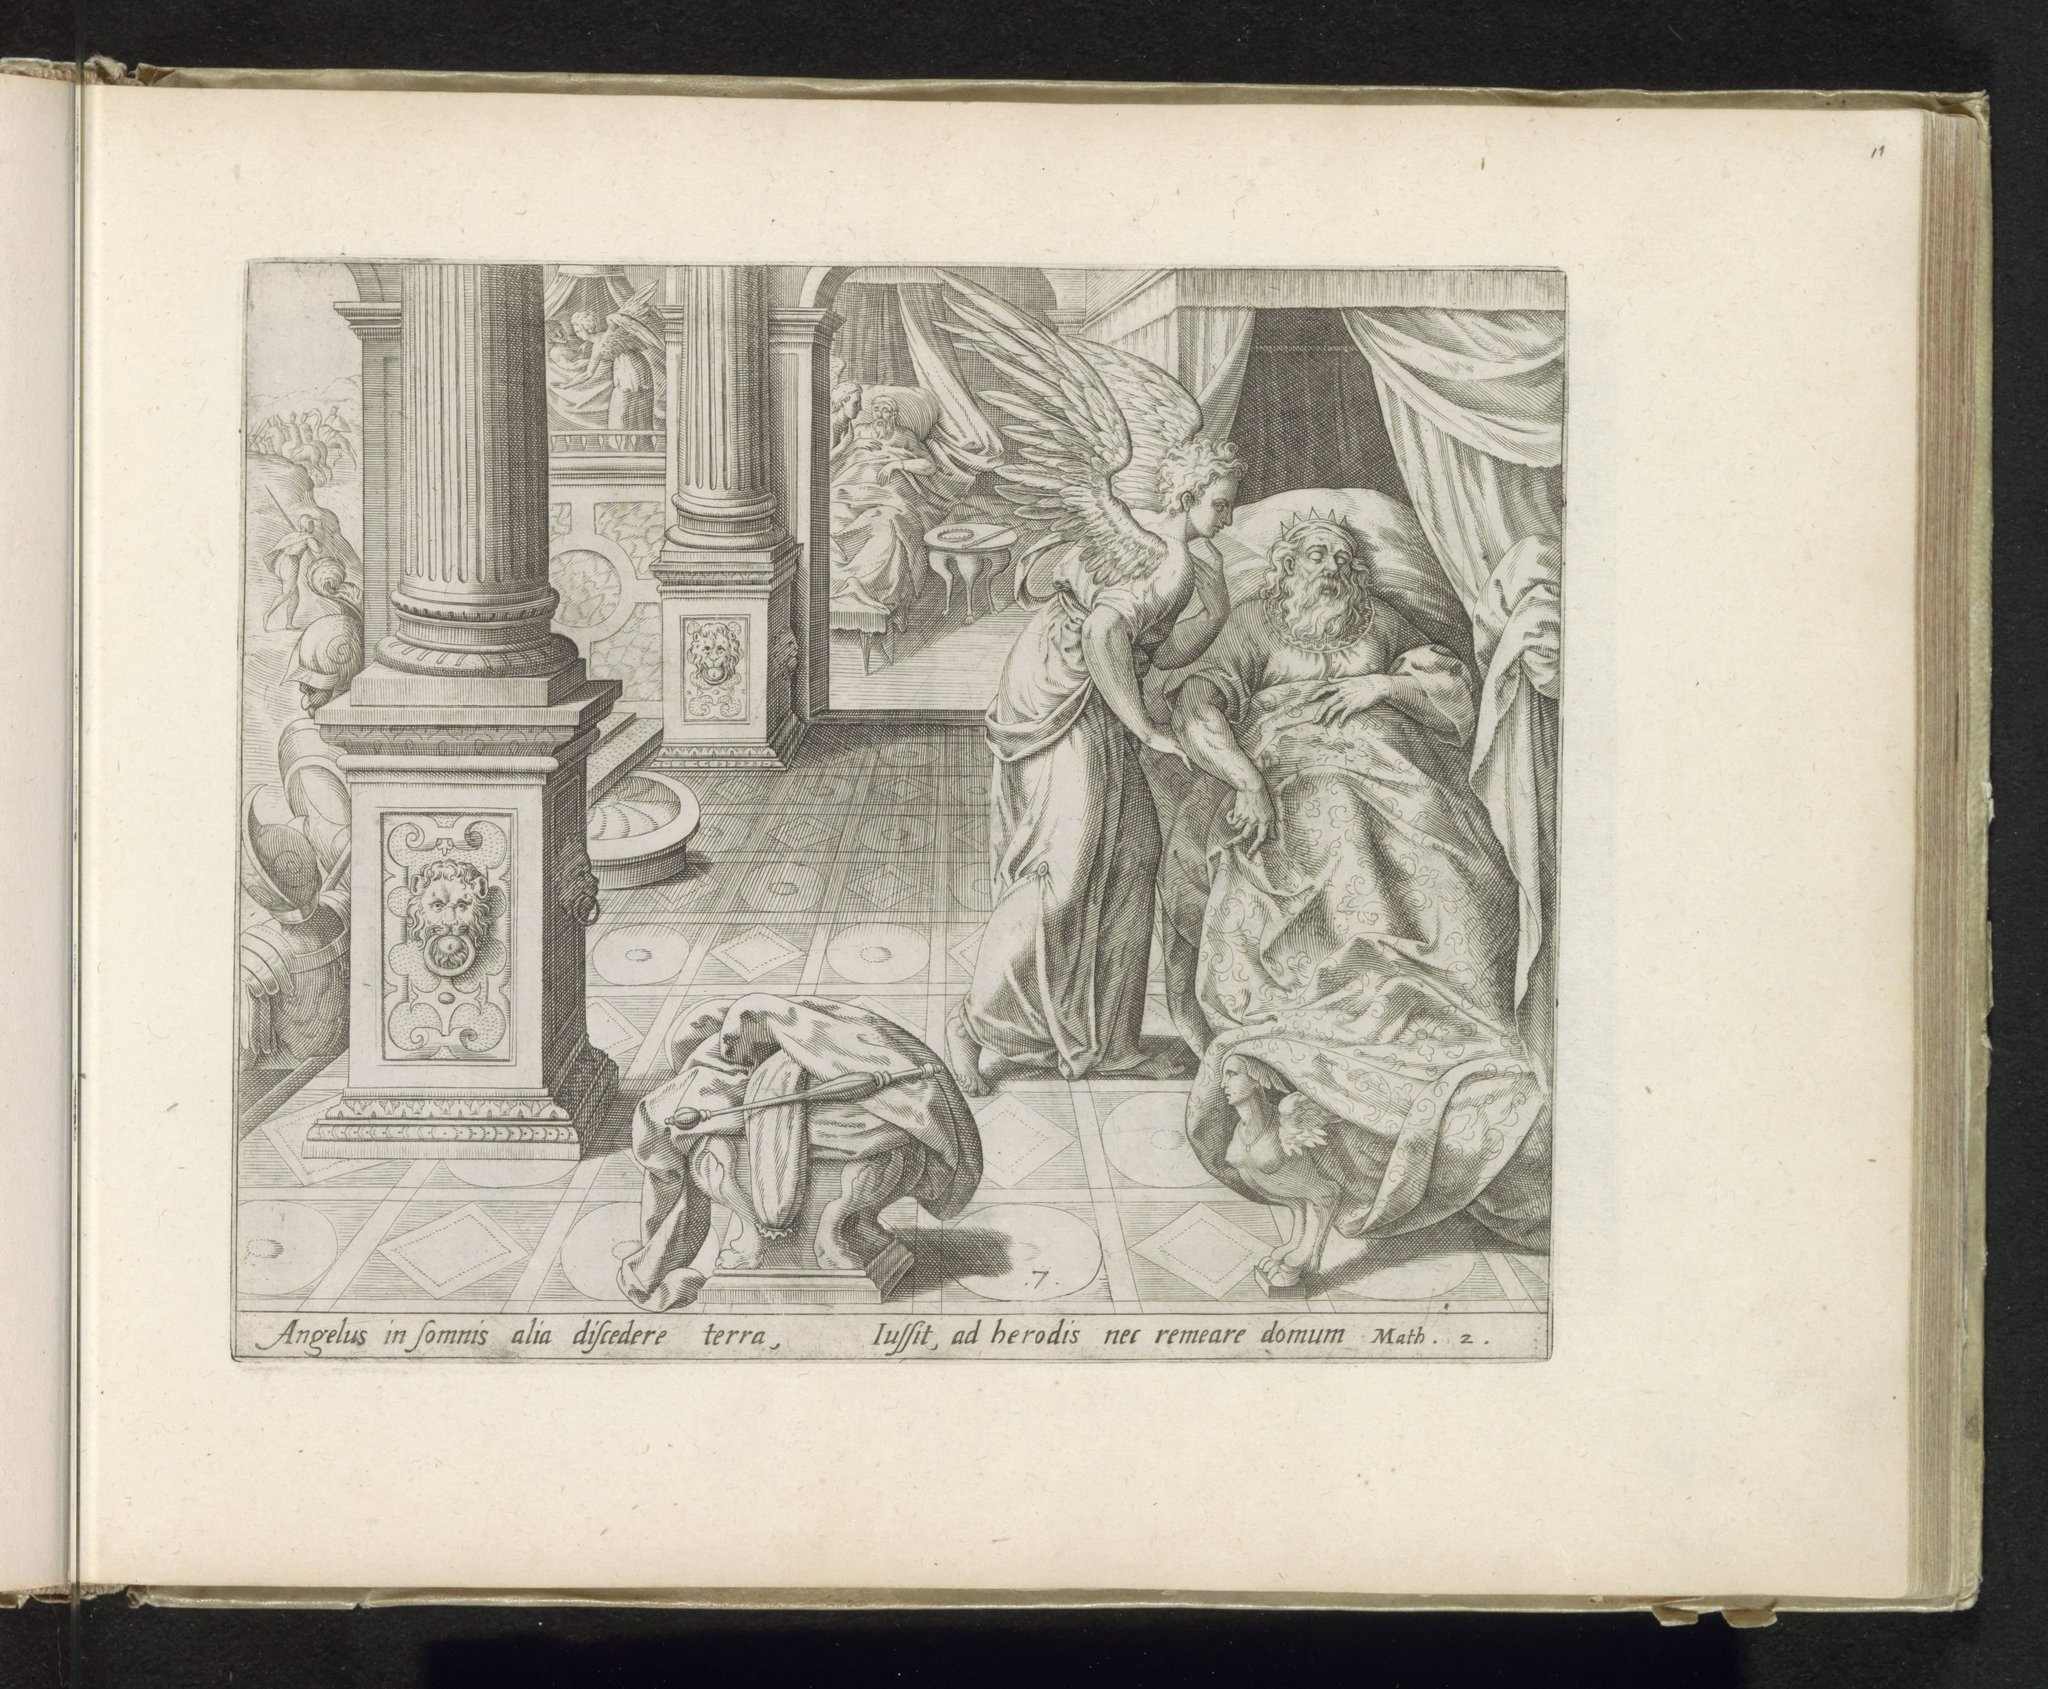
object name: print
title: De drie koningen in een droom gewaarschuwd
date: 1585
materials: paper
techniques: engraving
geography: antwerp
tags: the three wise men are warned in a dream by an angel not to return to herod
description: De drie koningen worden in een droom gewaarschuwd om niet naar Herodes terug te keren. Naast het bed van iedere koning staat een engel die dit hen influistert. Onder de voorstelling een verwijzing in het Latijn naar de Bijbeltekst in Mat. 2. Deze prent maakt deel uit van een album.